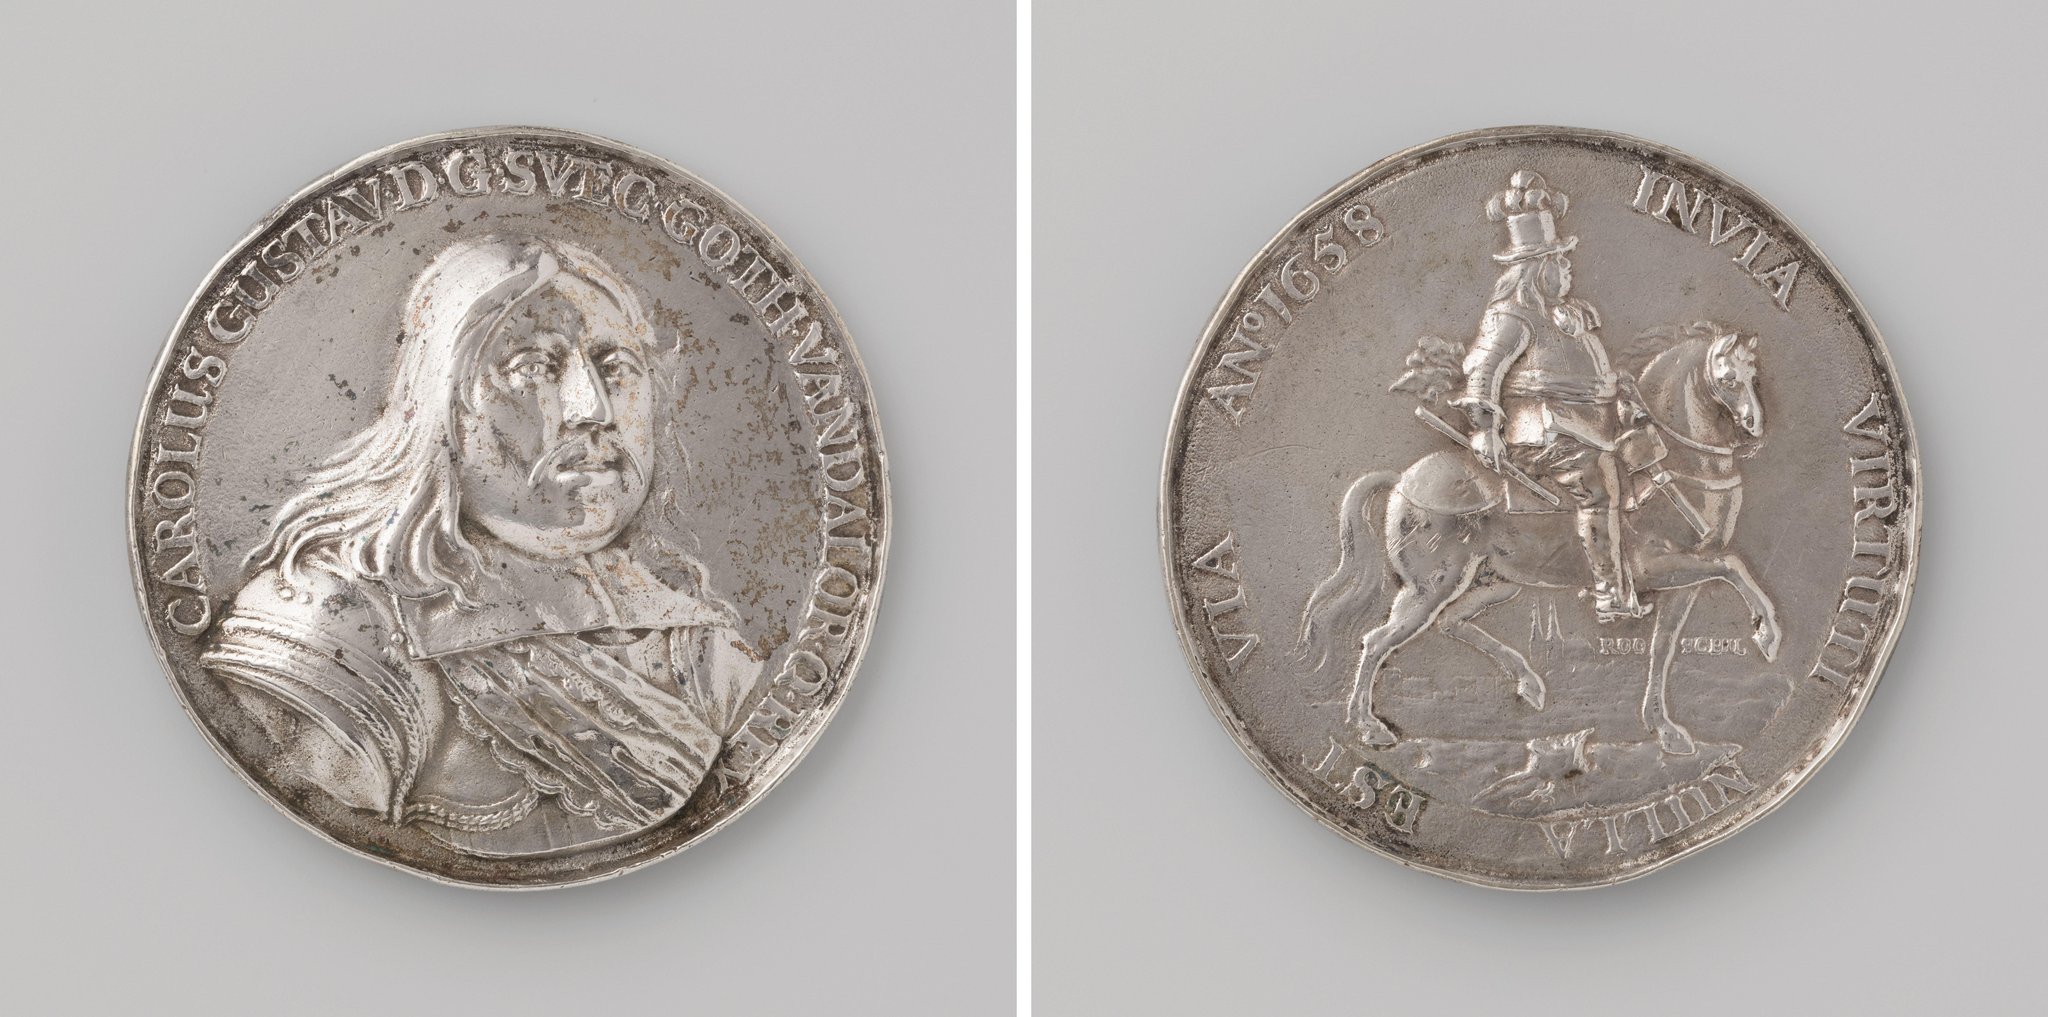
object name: history medal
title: Roemrijke tocht van Karel X Gustaaf van Zweden over de Belt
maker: pieter van abeele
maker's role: draughtsman, jeweler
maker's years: 1608-1684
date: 1658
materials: silver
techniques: striking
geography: amsterdam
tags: nyköping, göteborg, koning, karel x gustaaf (koning van zweden), faeröer, grote belt, roskilde, noordse oorlogen, tocht over de belt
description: Zilveren penning. Voorzijde: borststuk man binnen omschrift. Keerzijde: man te paard voor stad Roskilde binnen omschrift